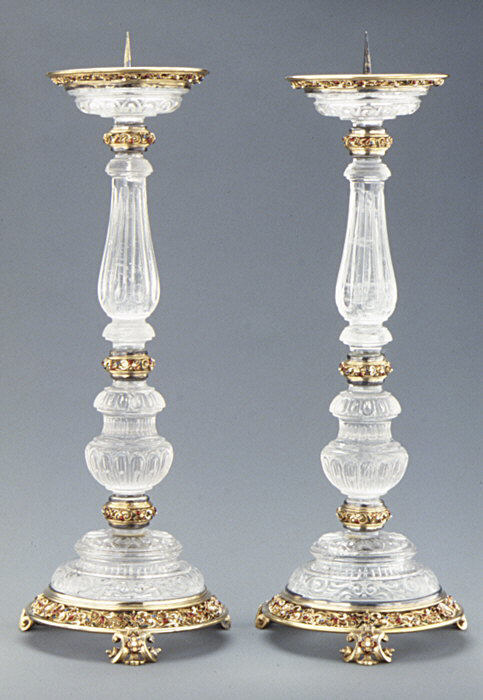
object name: pricket candlestick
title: Pair of pricket candlesticks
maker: reinhold vasters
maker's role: designer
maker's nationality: german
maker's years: 1827-1909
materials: crystal, enamel, silver gilt